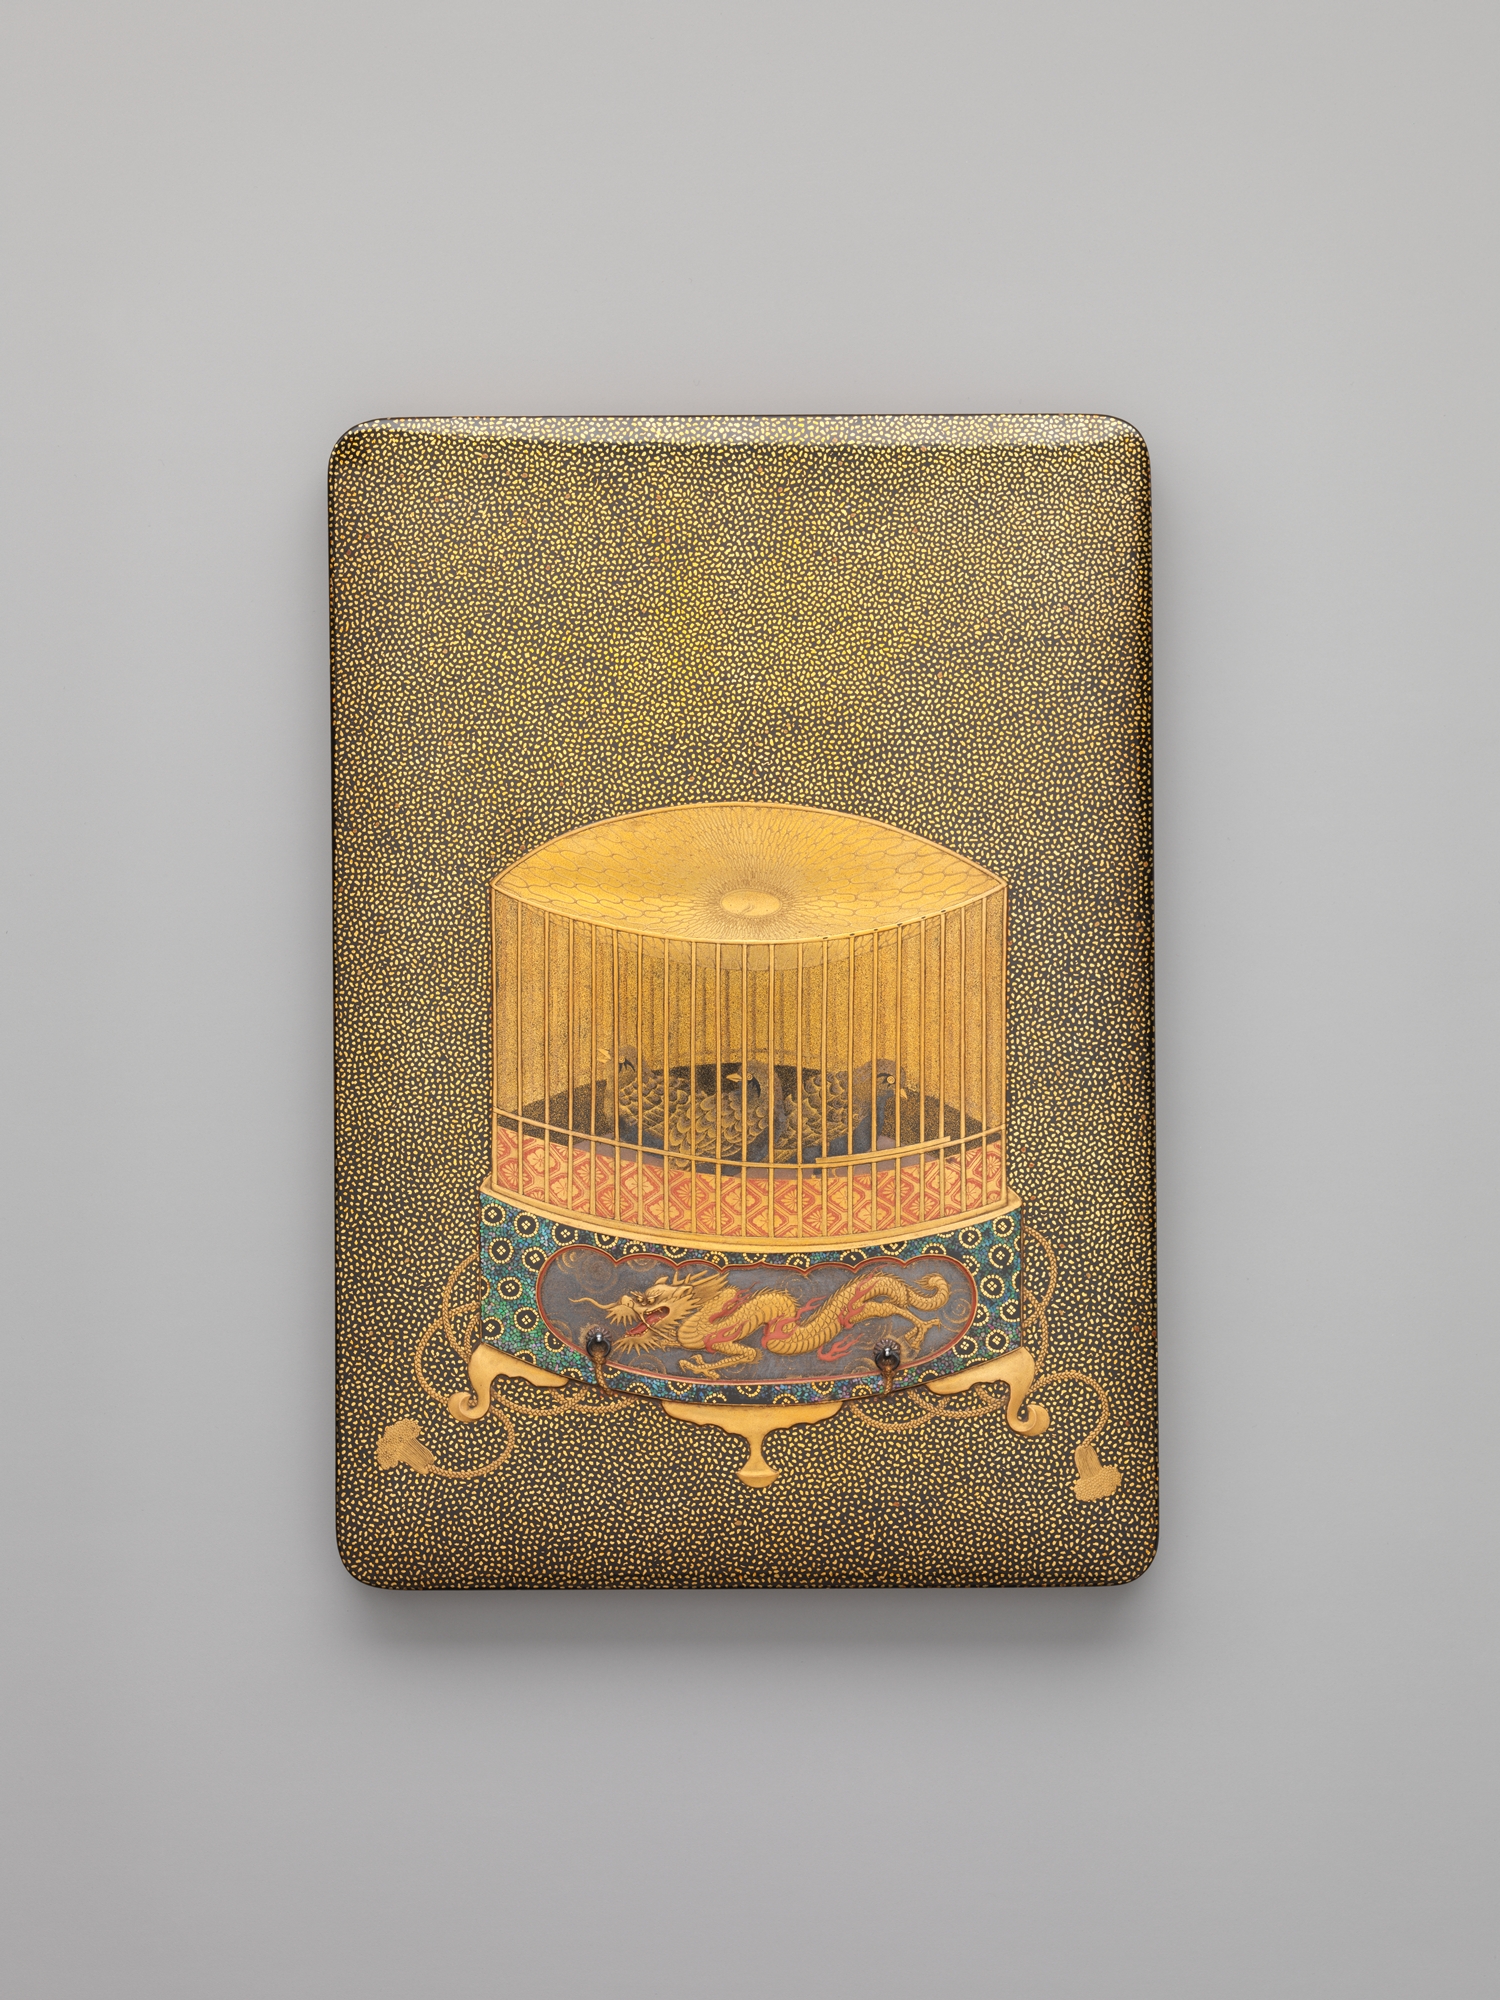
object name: writing box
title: Writing Box with Birdcage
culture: japanese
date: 1801-1900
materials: gold, lacquer, mother of pearl, silver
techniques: hiramakie, inlay, maki-e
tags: birds,dragons